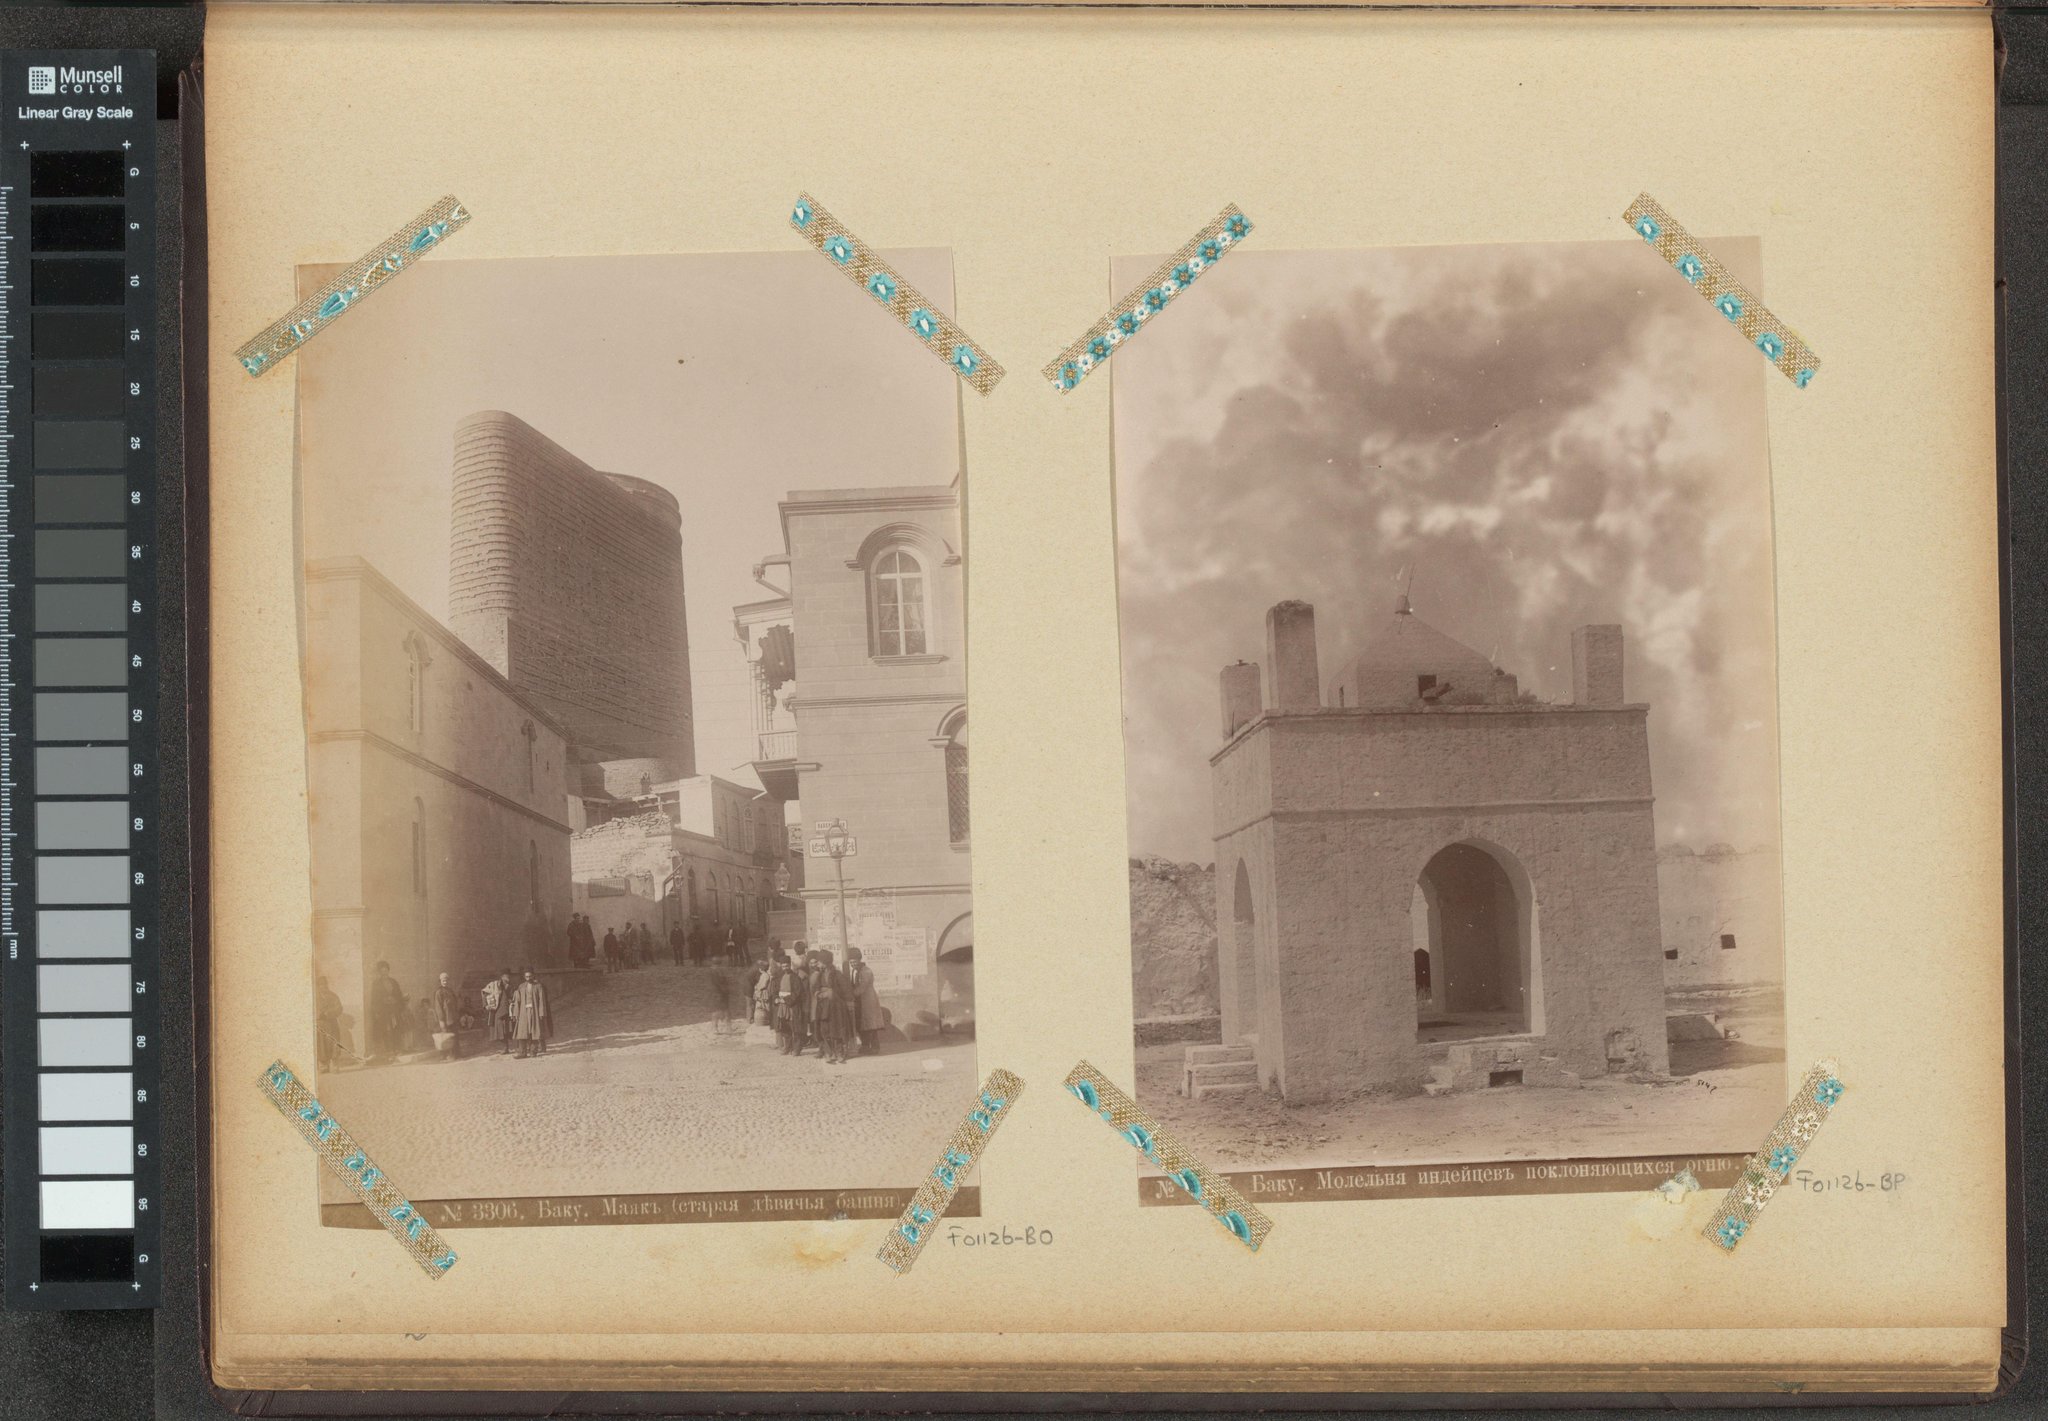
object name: photograph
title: Bakoe Majak (staraja dwitsja datsjia)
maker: Anonymous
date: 1890-1900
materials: photographic support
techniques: albumen print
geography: baku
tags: lighthouse, lightship, sloping street; street with steps or stairs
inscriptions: number: ‘3306’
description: Onderdeel van Fotoalbum met opnames van bezienswaardigheden in Georgië, Sint-Petersburg en Moskou.